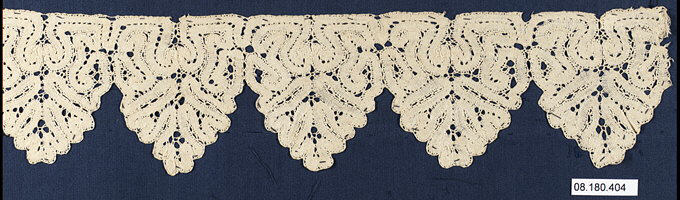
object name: fragment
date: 1601-1700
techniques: lace